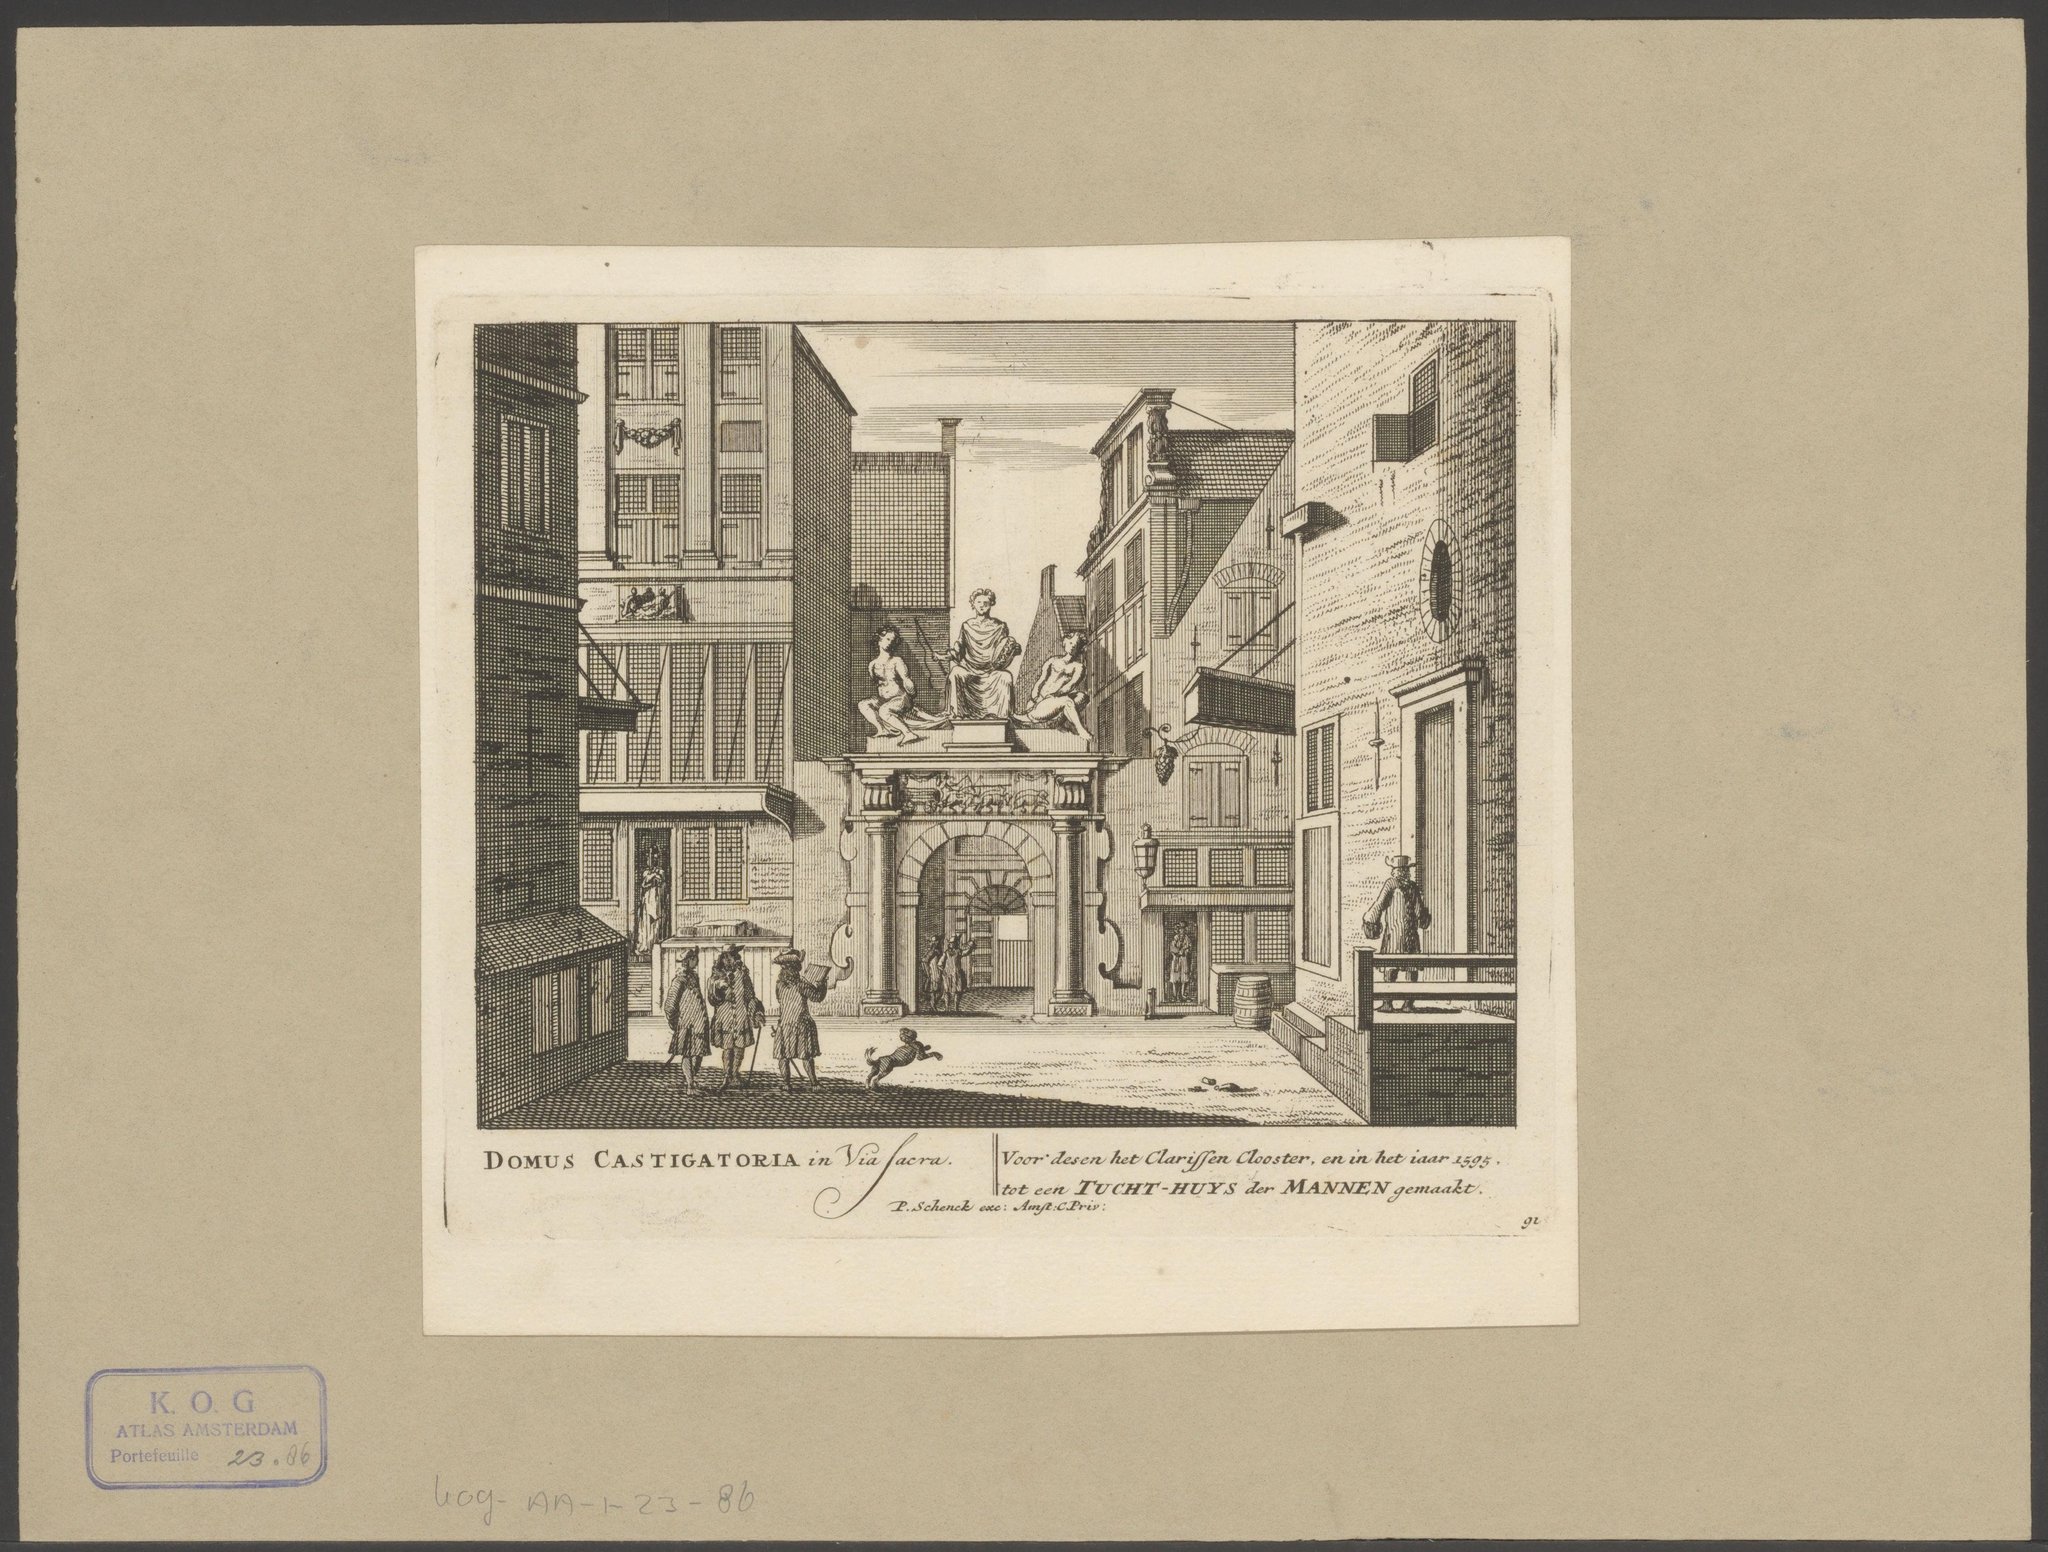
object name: print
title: Domus Castigatoria in Via Sacra / Voor desen het Clarissen Clooster, en in het iaar 1595, tot een Tucht-huys der mannen gemaakt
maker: Anonymous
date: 1710-1711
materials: paper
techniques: engraving, etching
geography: northern netherlands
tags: prison, jail, gate, entrance, workhouse, penal camp, penitentiary, chain gang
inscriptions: collector's mark: Lugt 1641b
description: Prent mogelijk uit: 100 Afbeeldinge der voornaamste gebouwen van Amsterdam. Amsterdam, Pieter Schenk (I), s.a. [1710-1711]. Of uit: 100 Afbeeldinge der voornaamste gebouwen van Amsterdam. Amsterdam: Barent Greve, s.a. [1757-1766]. In de tweede uitgave, uitgegeven door Barent Greve, is alleen de titelprent aangepast. De overige prenten zijn onveranderd gebleven.